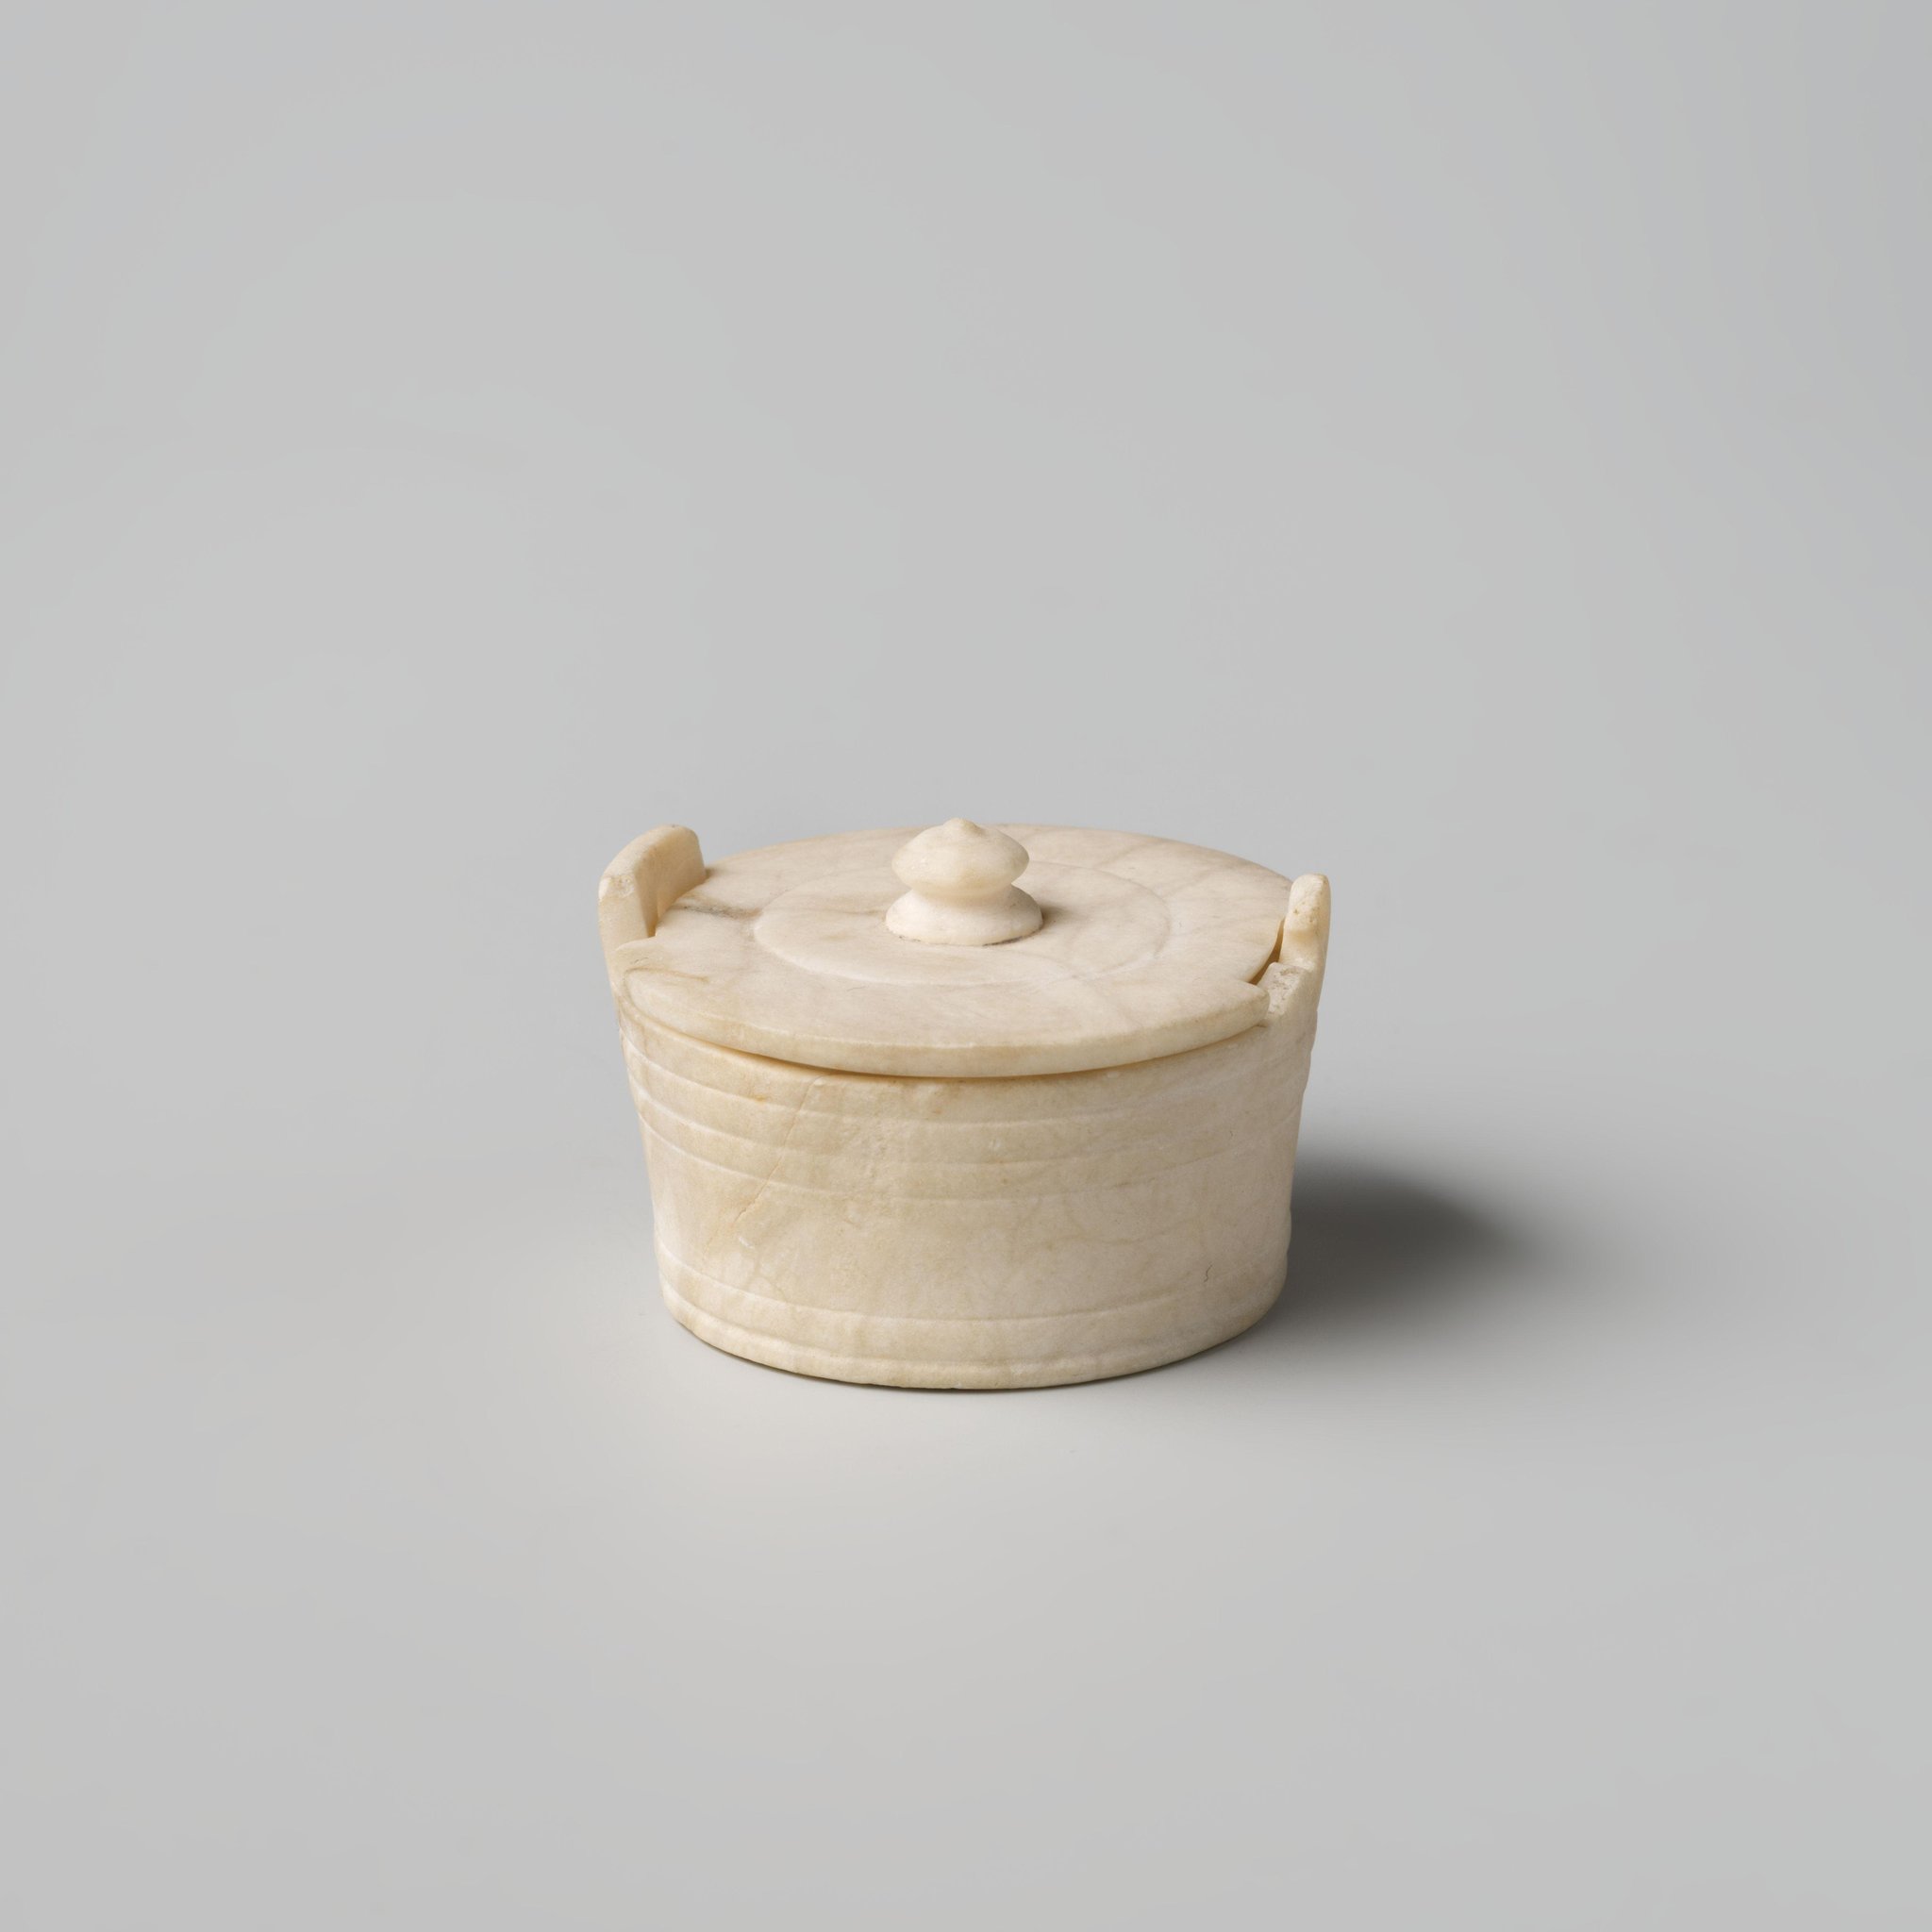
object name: miniature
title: Boterpot van albast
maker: Anonymous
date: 1650-1699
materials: alabaster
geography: netherlands